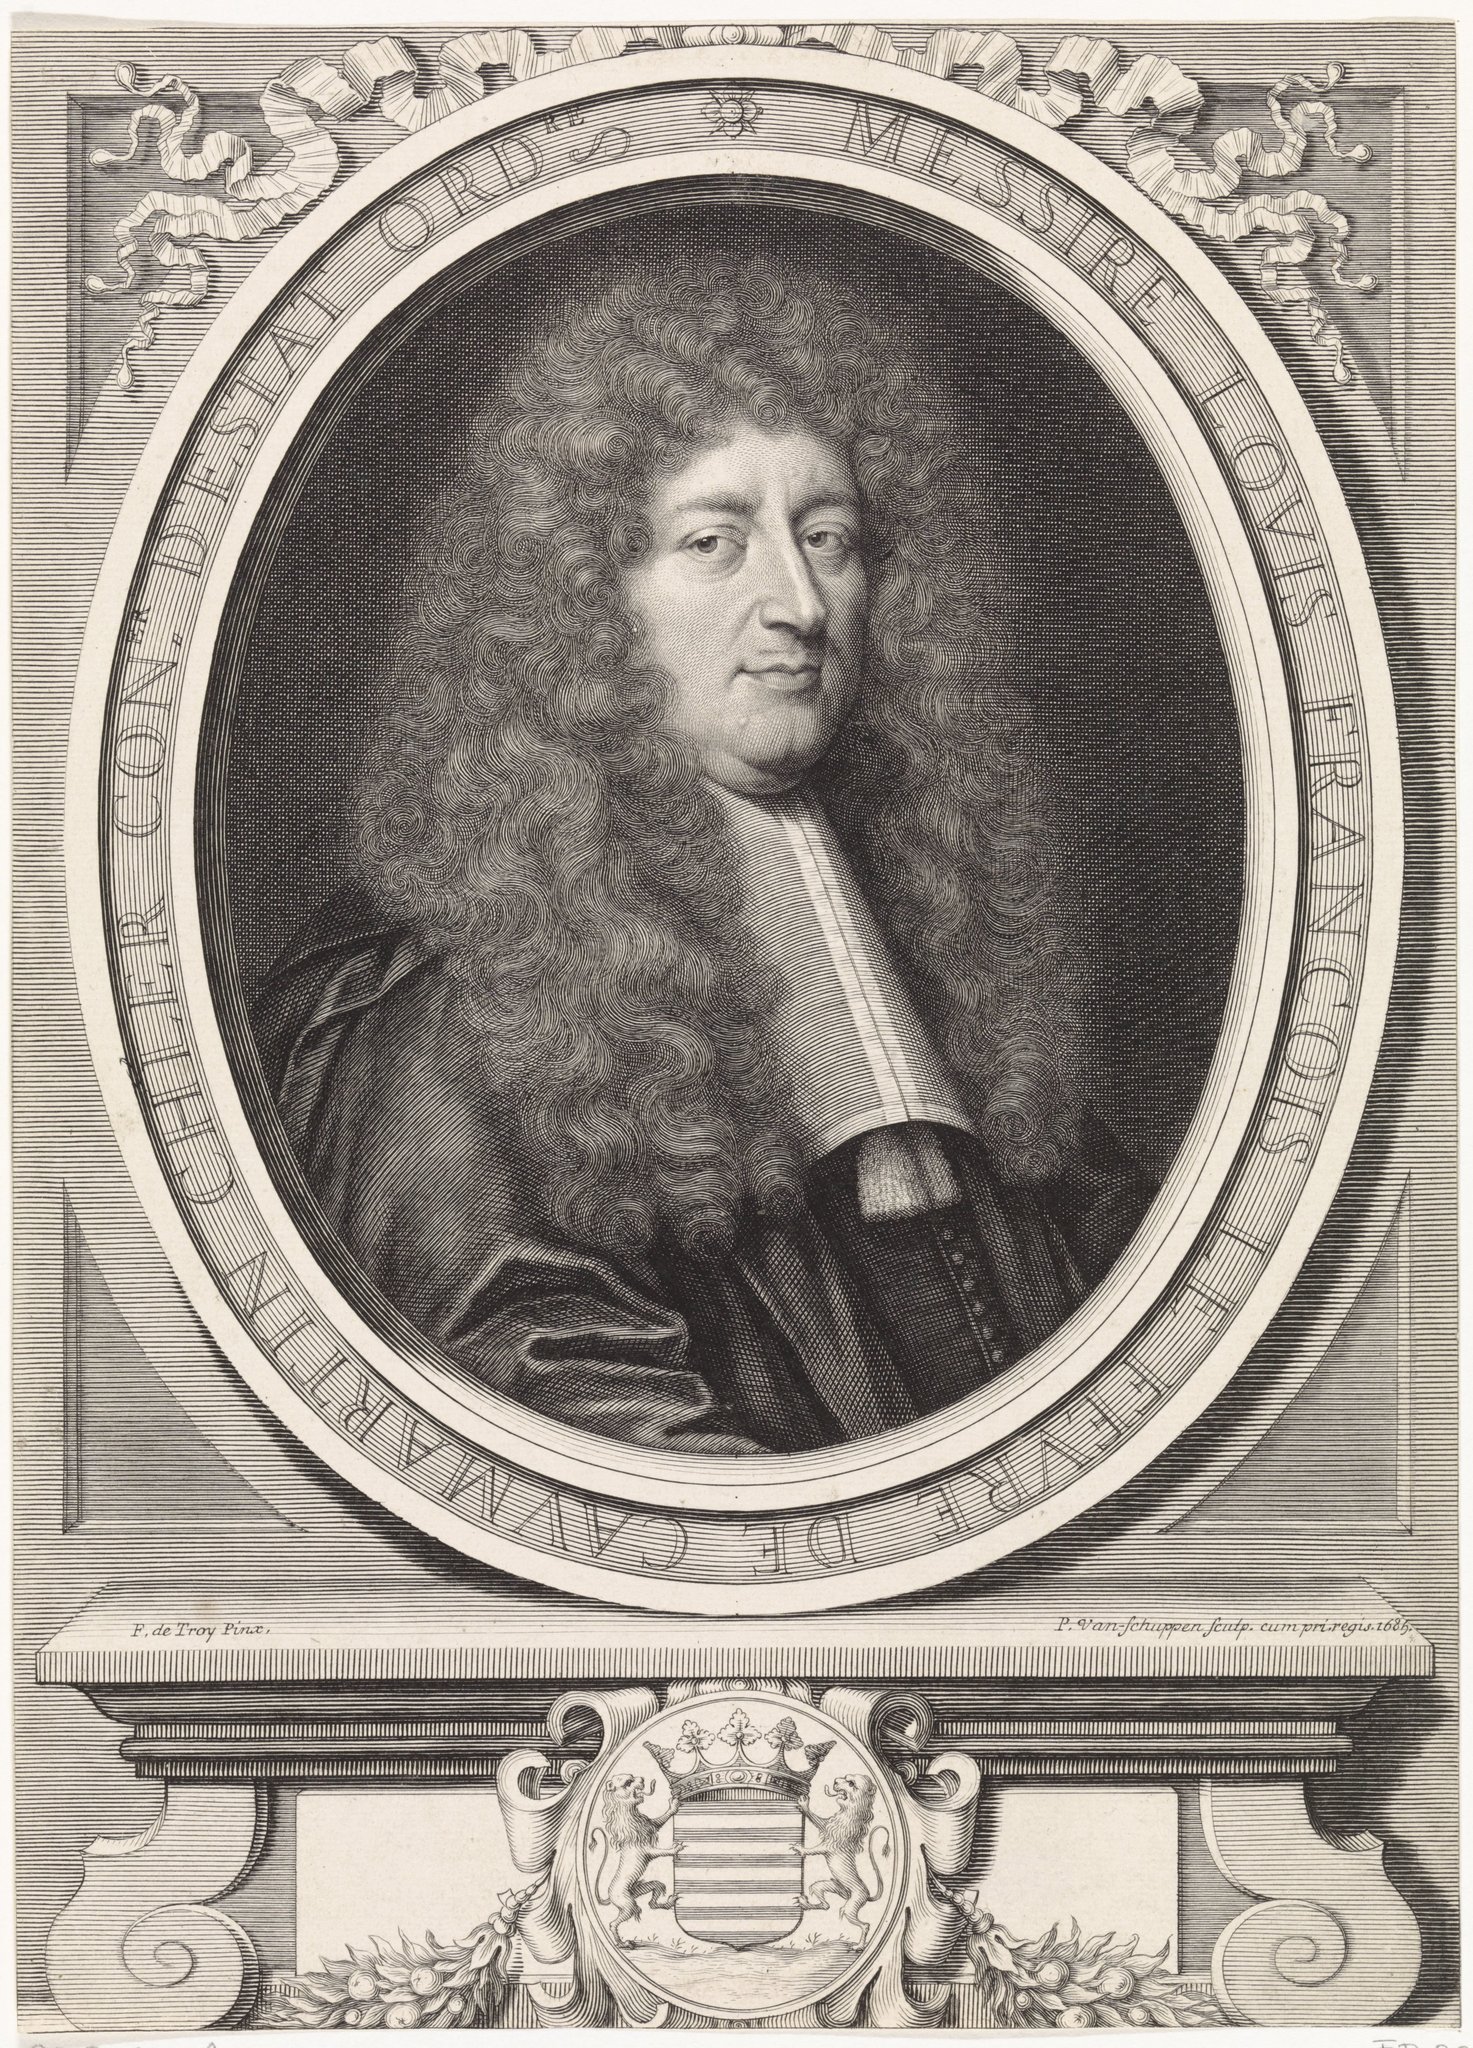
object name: print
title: Portret van de Franse staatsman Louis-François Le Fèvre de Caumartin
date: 1604-1685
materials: paper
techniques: engraving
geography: paris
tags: staatsman, louis-françois le fèvre de caumartin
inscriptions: collector's mark: Lugt 2228